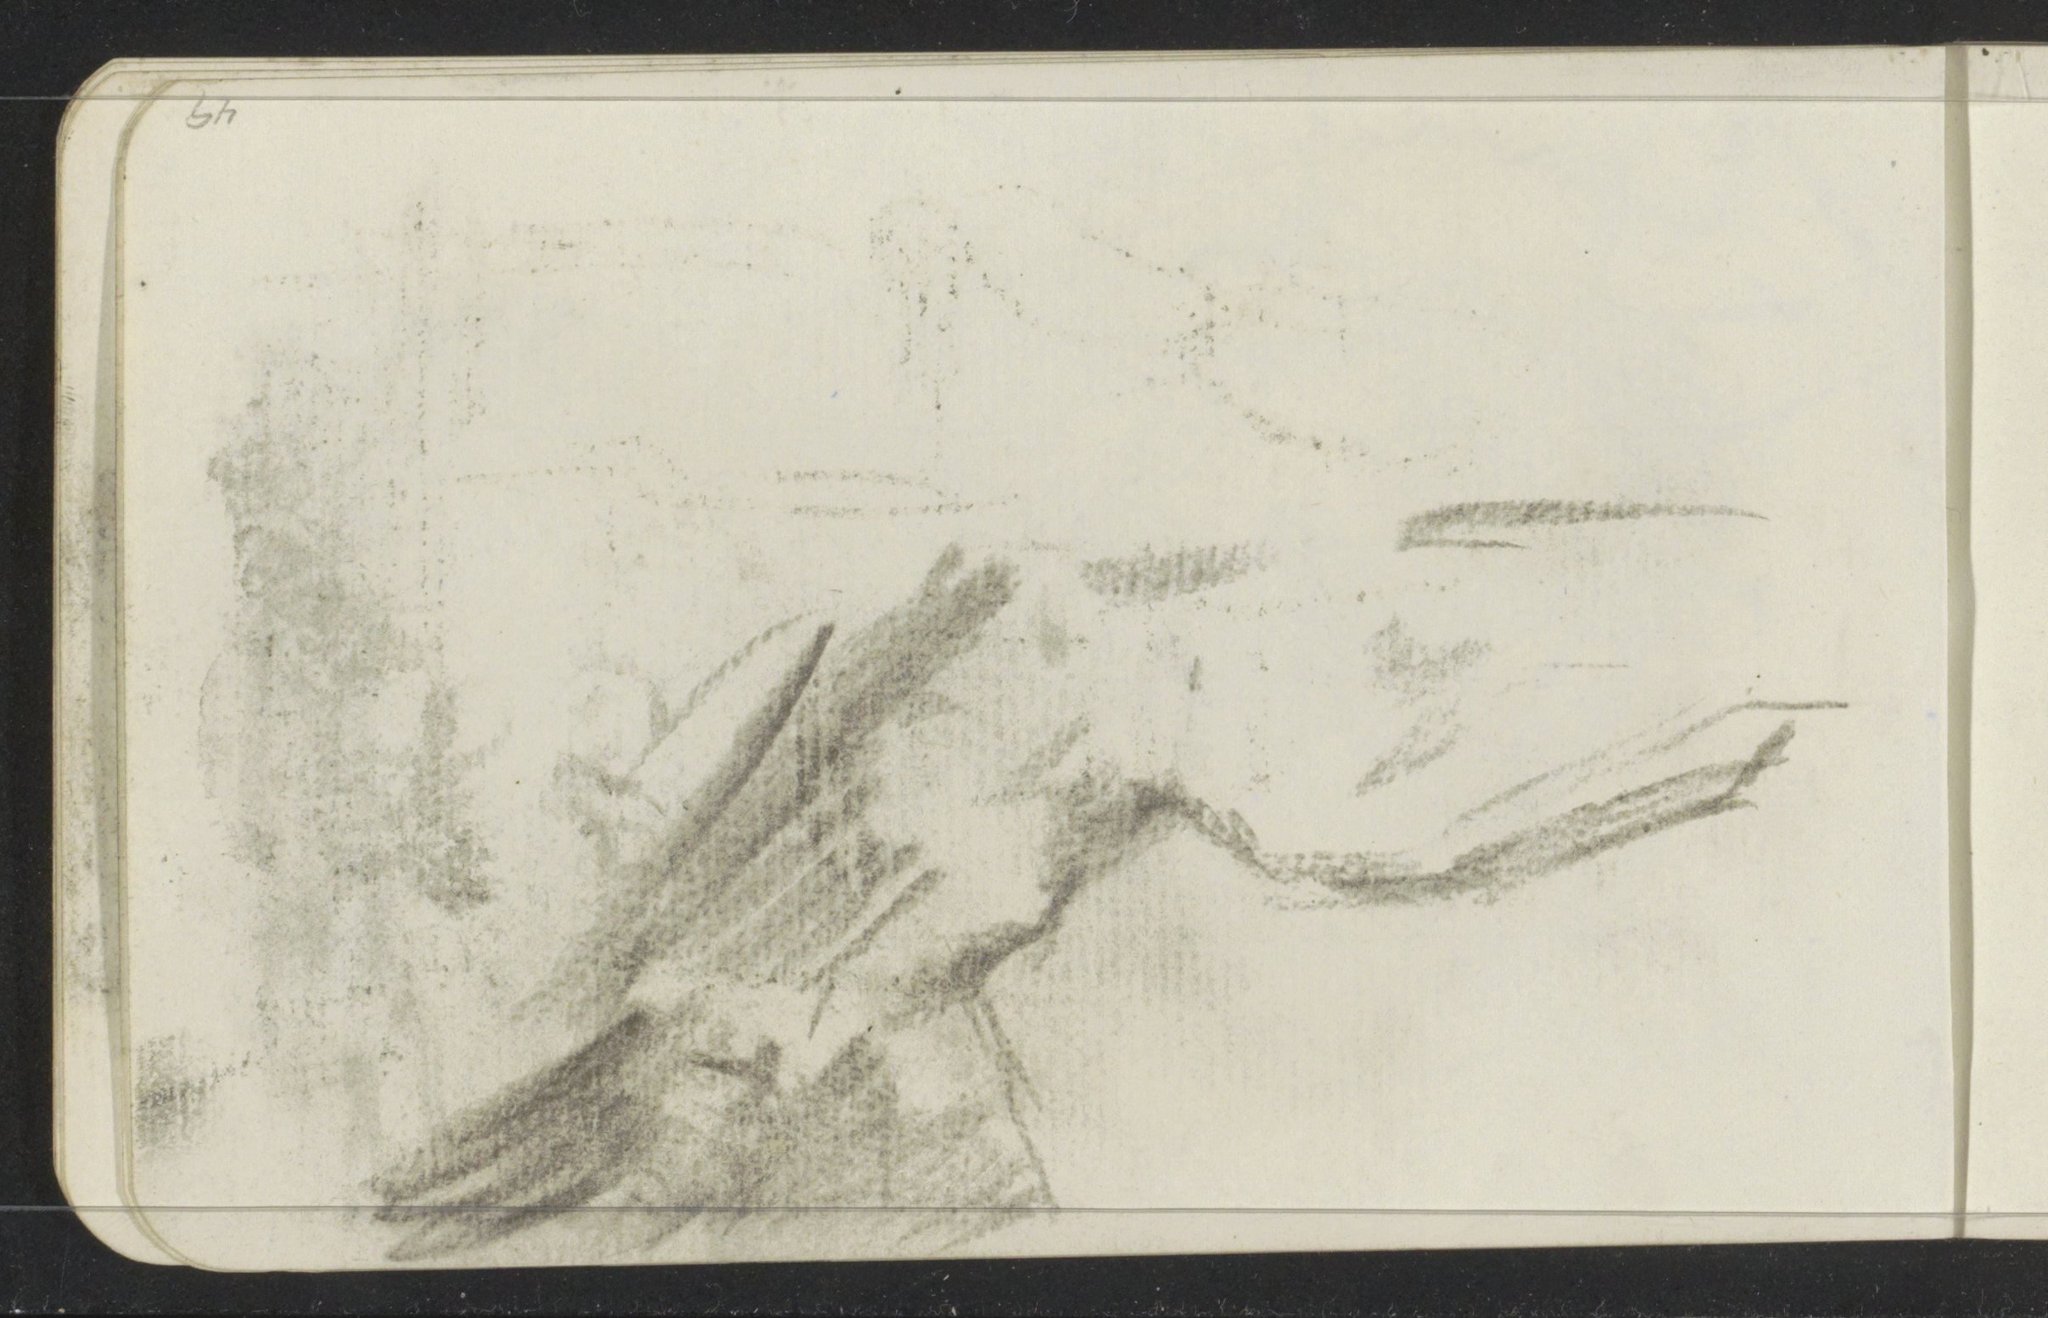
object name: sketchbook leaf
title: Reclining Female Nude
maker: isaac israels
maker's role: draughtsman, painter, print maker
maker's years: 1865-1934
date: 1875-1934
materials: charcoal, paper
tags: the (nude) human figure; 'corpo humano' (ripa) - aa - female human figure (+ lying)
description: Blad 7 verso uit schetsboek LXII met 28 bladen.